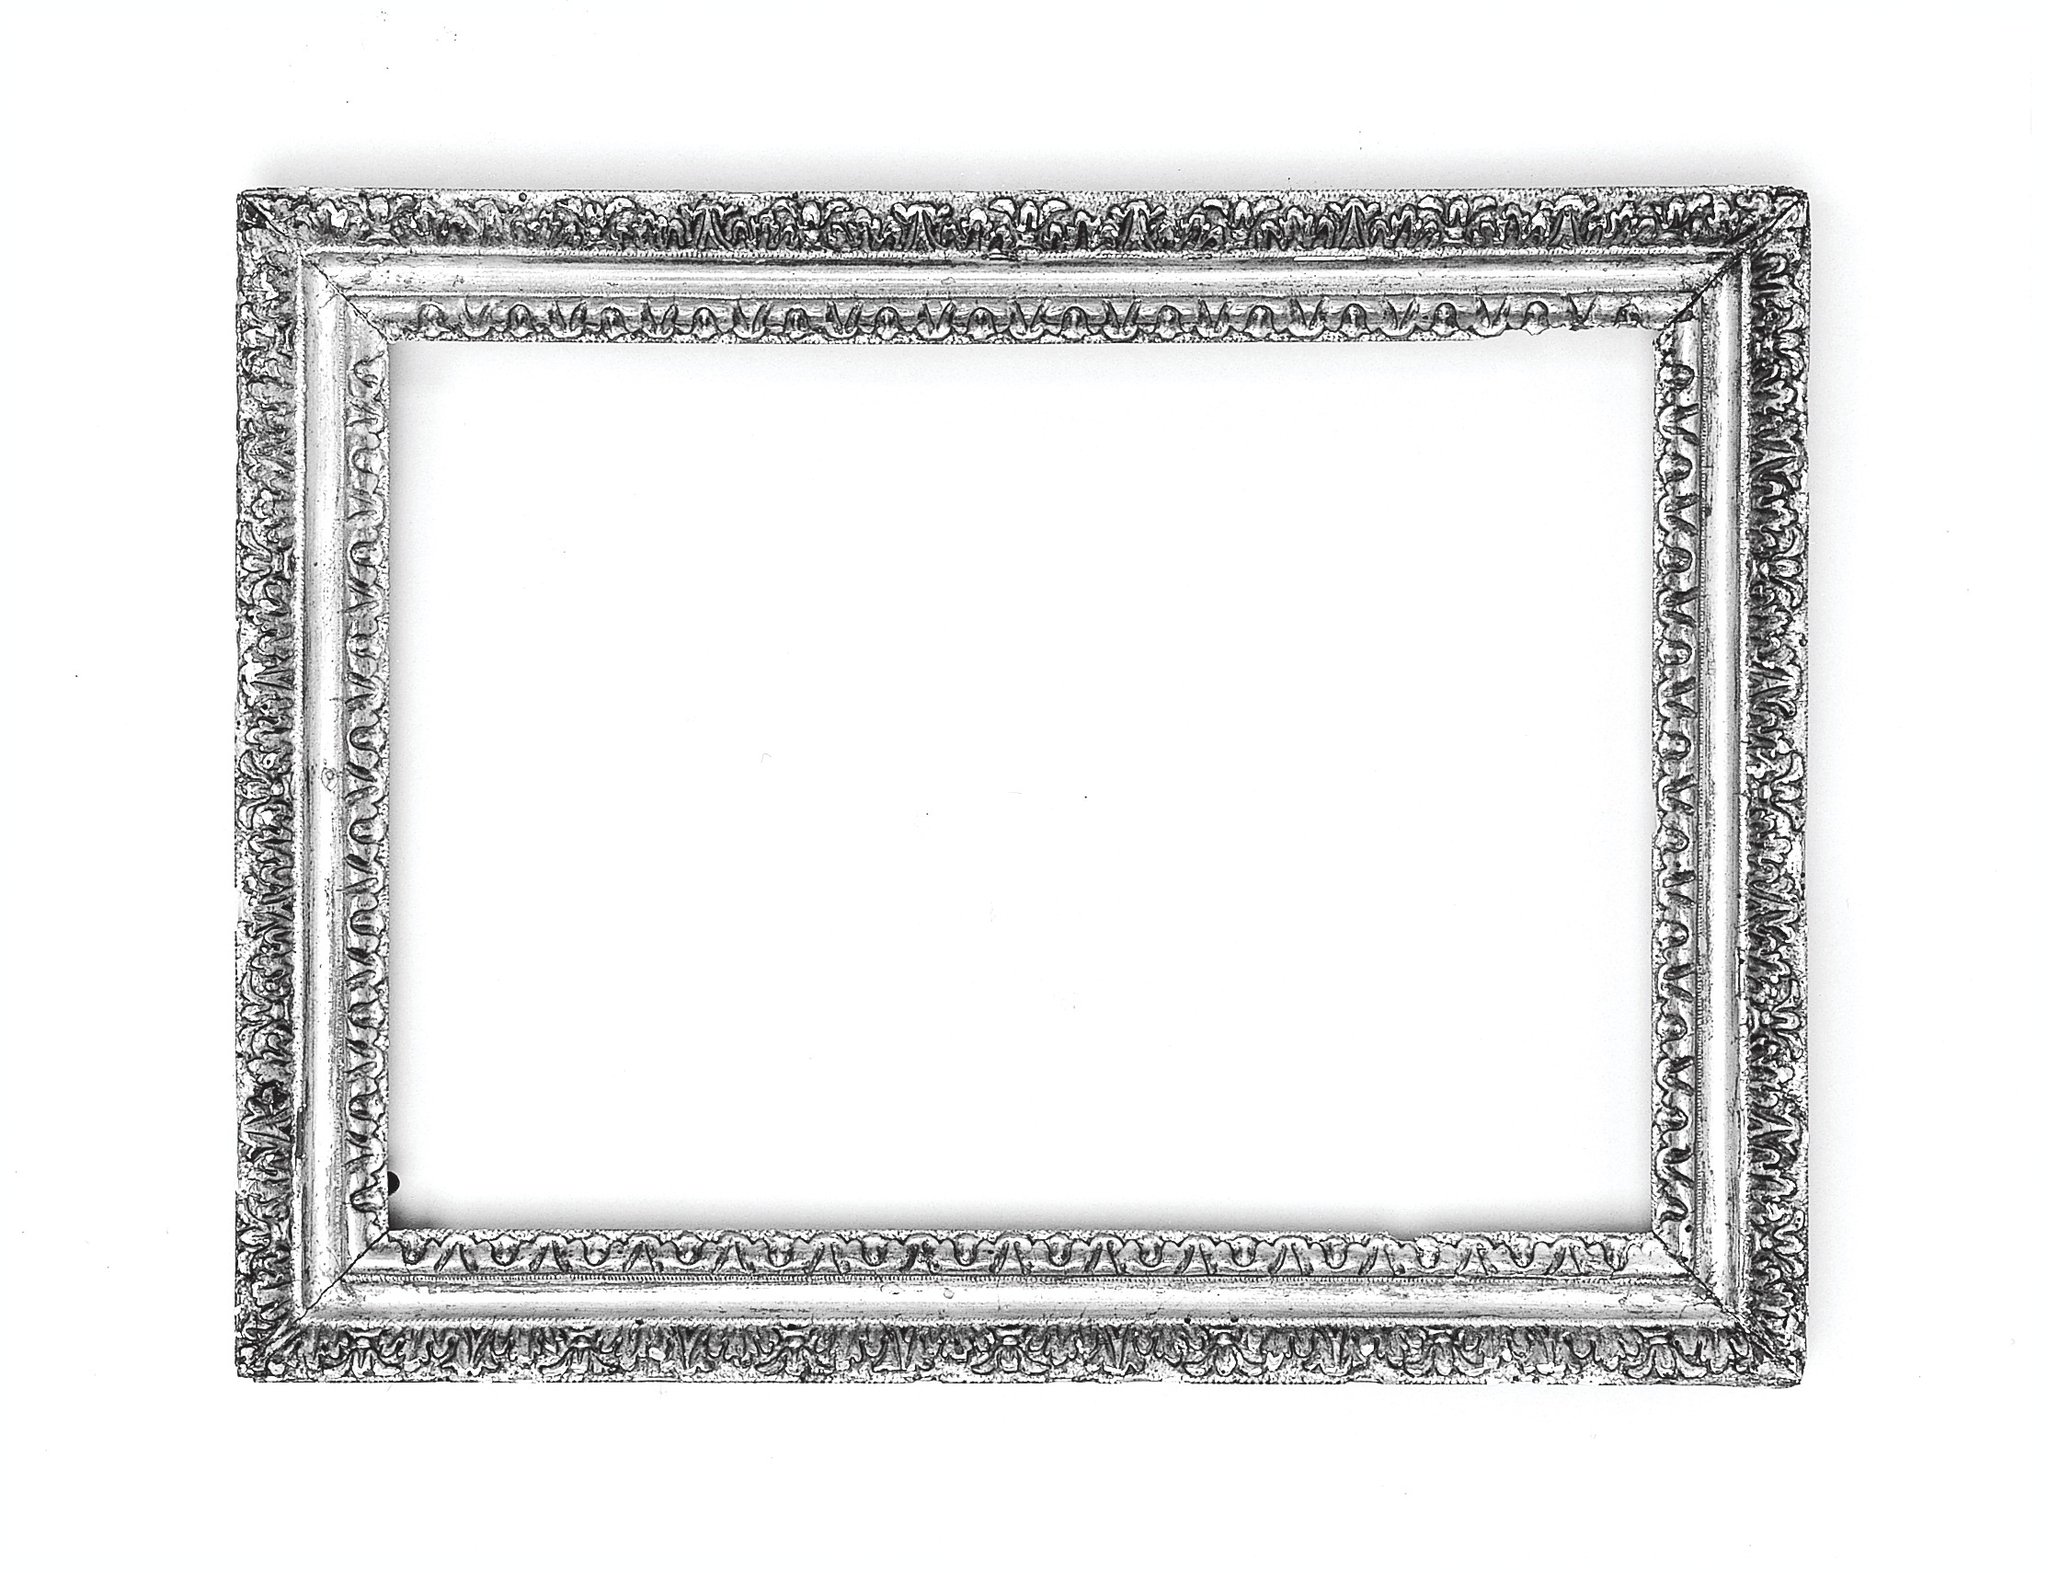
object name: frame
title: Ovolo frame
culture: french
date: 1670-1680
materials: feather, wood